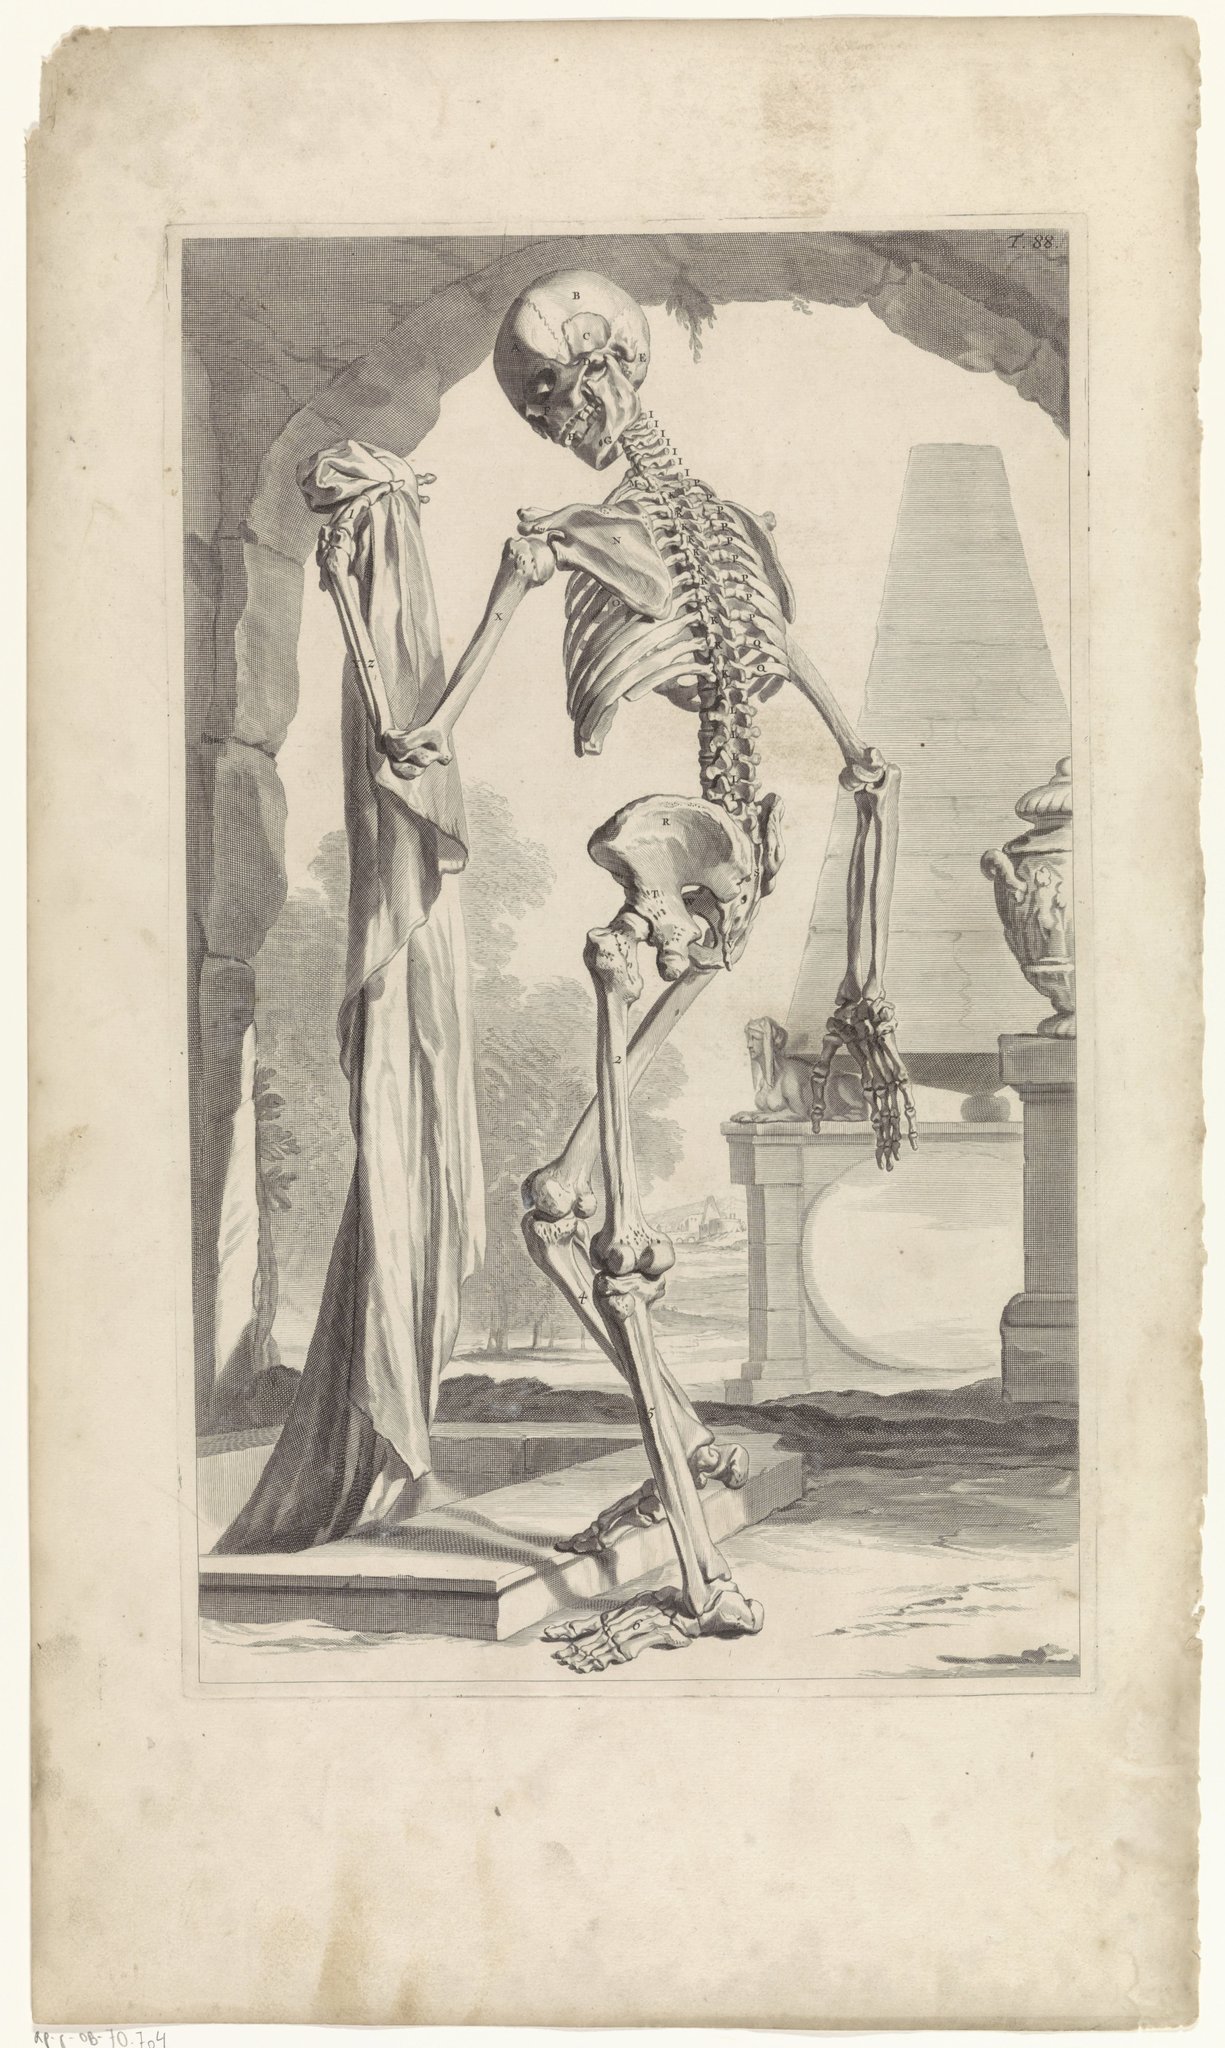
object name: print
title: Anatomische model van een menselijk skelet (achterkant)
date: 1685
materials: paper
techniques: engraving, etching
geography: amsterdam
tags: grave, tomb, (human) skeleton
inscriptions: collector's mark: Lugt 2228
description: Boekillustratie voor Bidloo, Godefridus. Anatomia humani corporis centum & quinque tabulis, per art. G. de Lairesse ad vivum delineatis, de monstrata, veterum recentiorumque inventis explicata plurimisque, hactenus non detectis, illustrata. Amsterdam: Weduwe Joannes van Someren, Hendrick Boom en erven Dirk Boom, 1685.